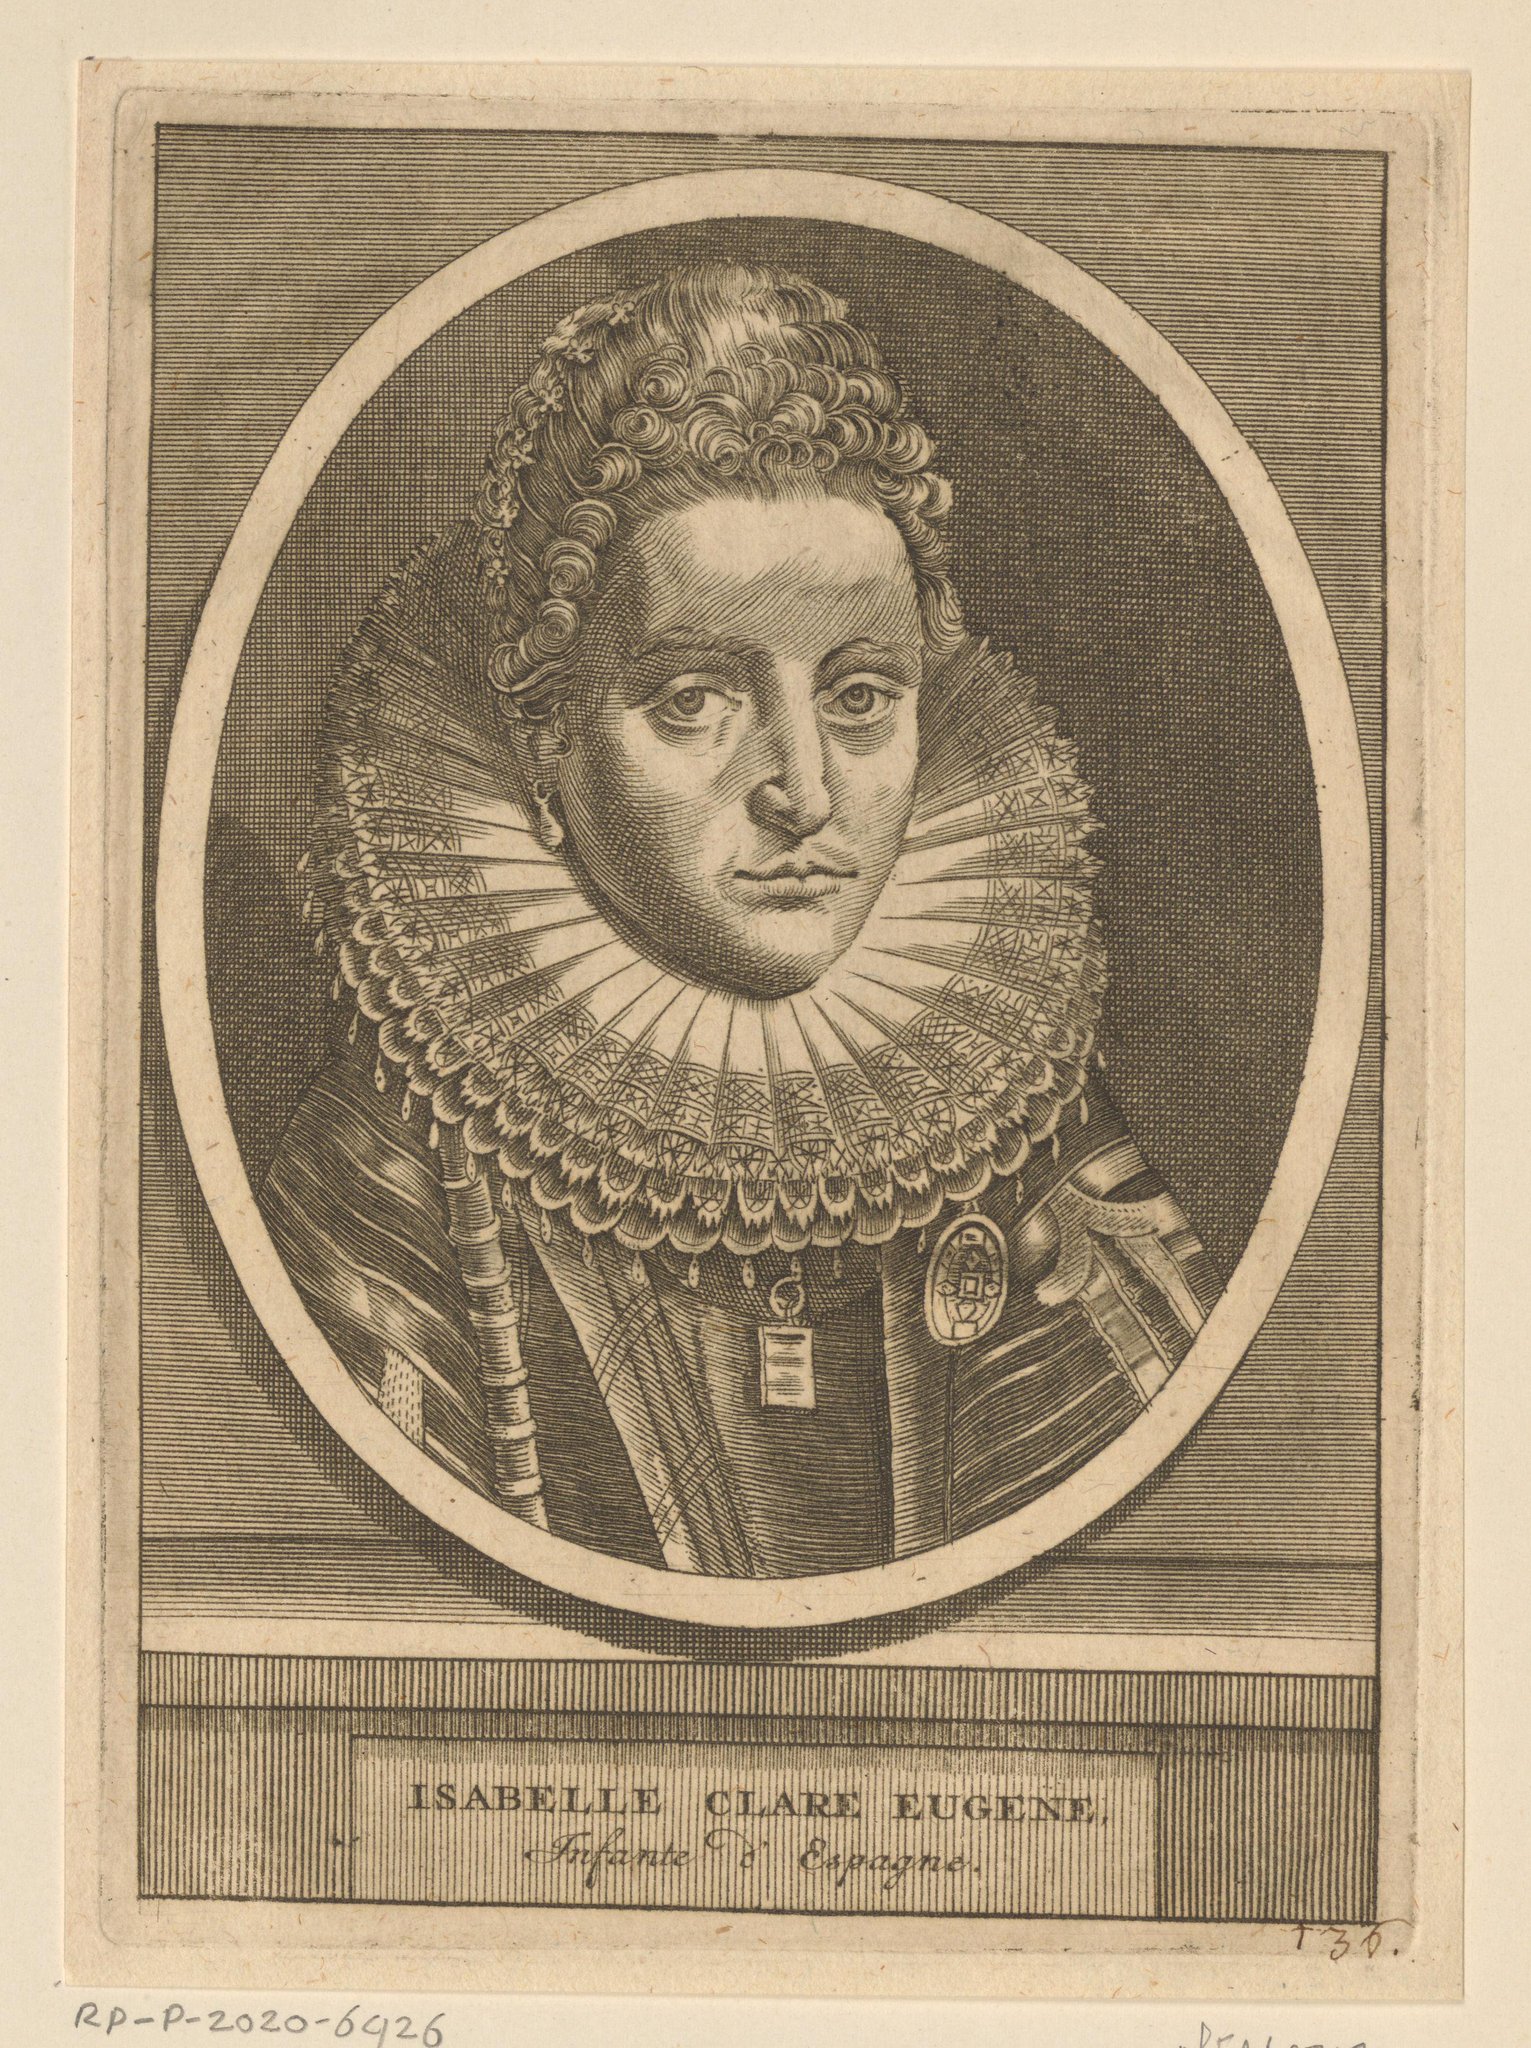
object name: print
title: Portret van Isabella Clara Eugenia, infante van Spanje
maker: Anonymous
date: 1650-1749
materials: paper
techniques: engraving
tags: infante van spanje isabella clara eugenia, historical persons - bb - woman, ruler, sovereign - bb - female ruler, neck-gear: collar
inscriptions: inscription: ‘+36’